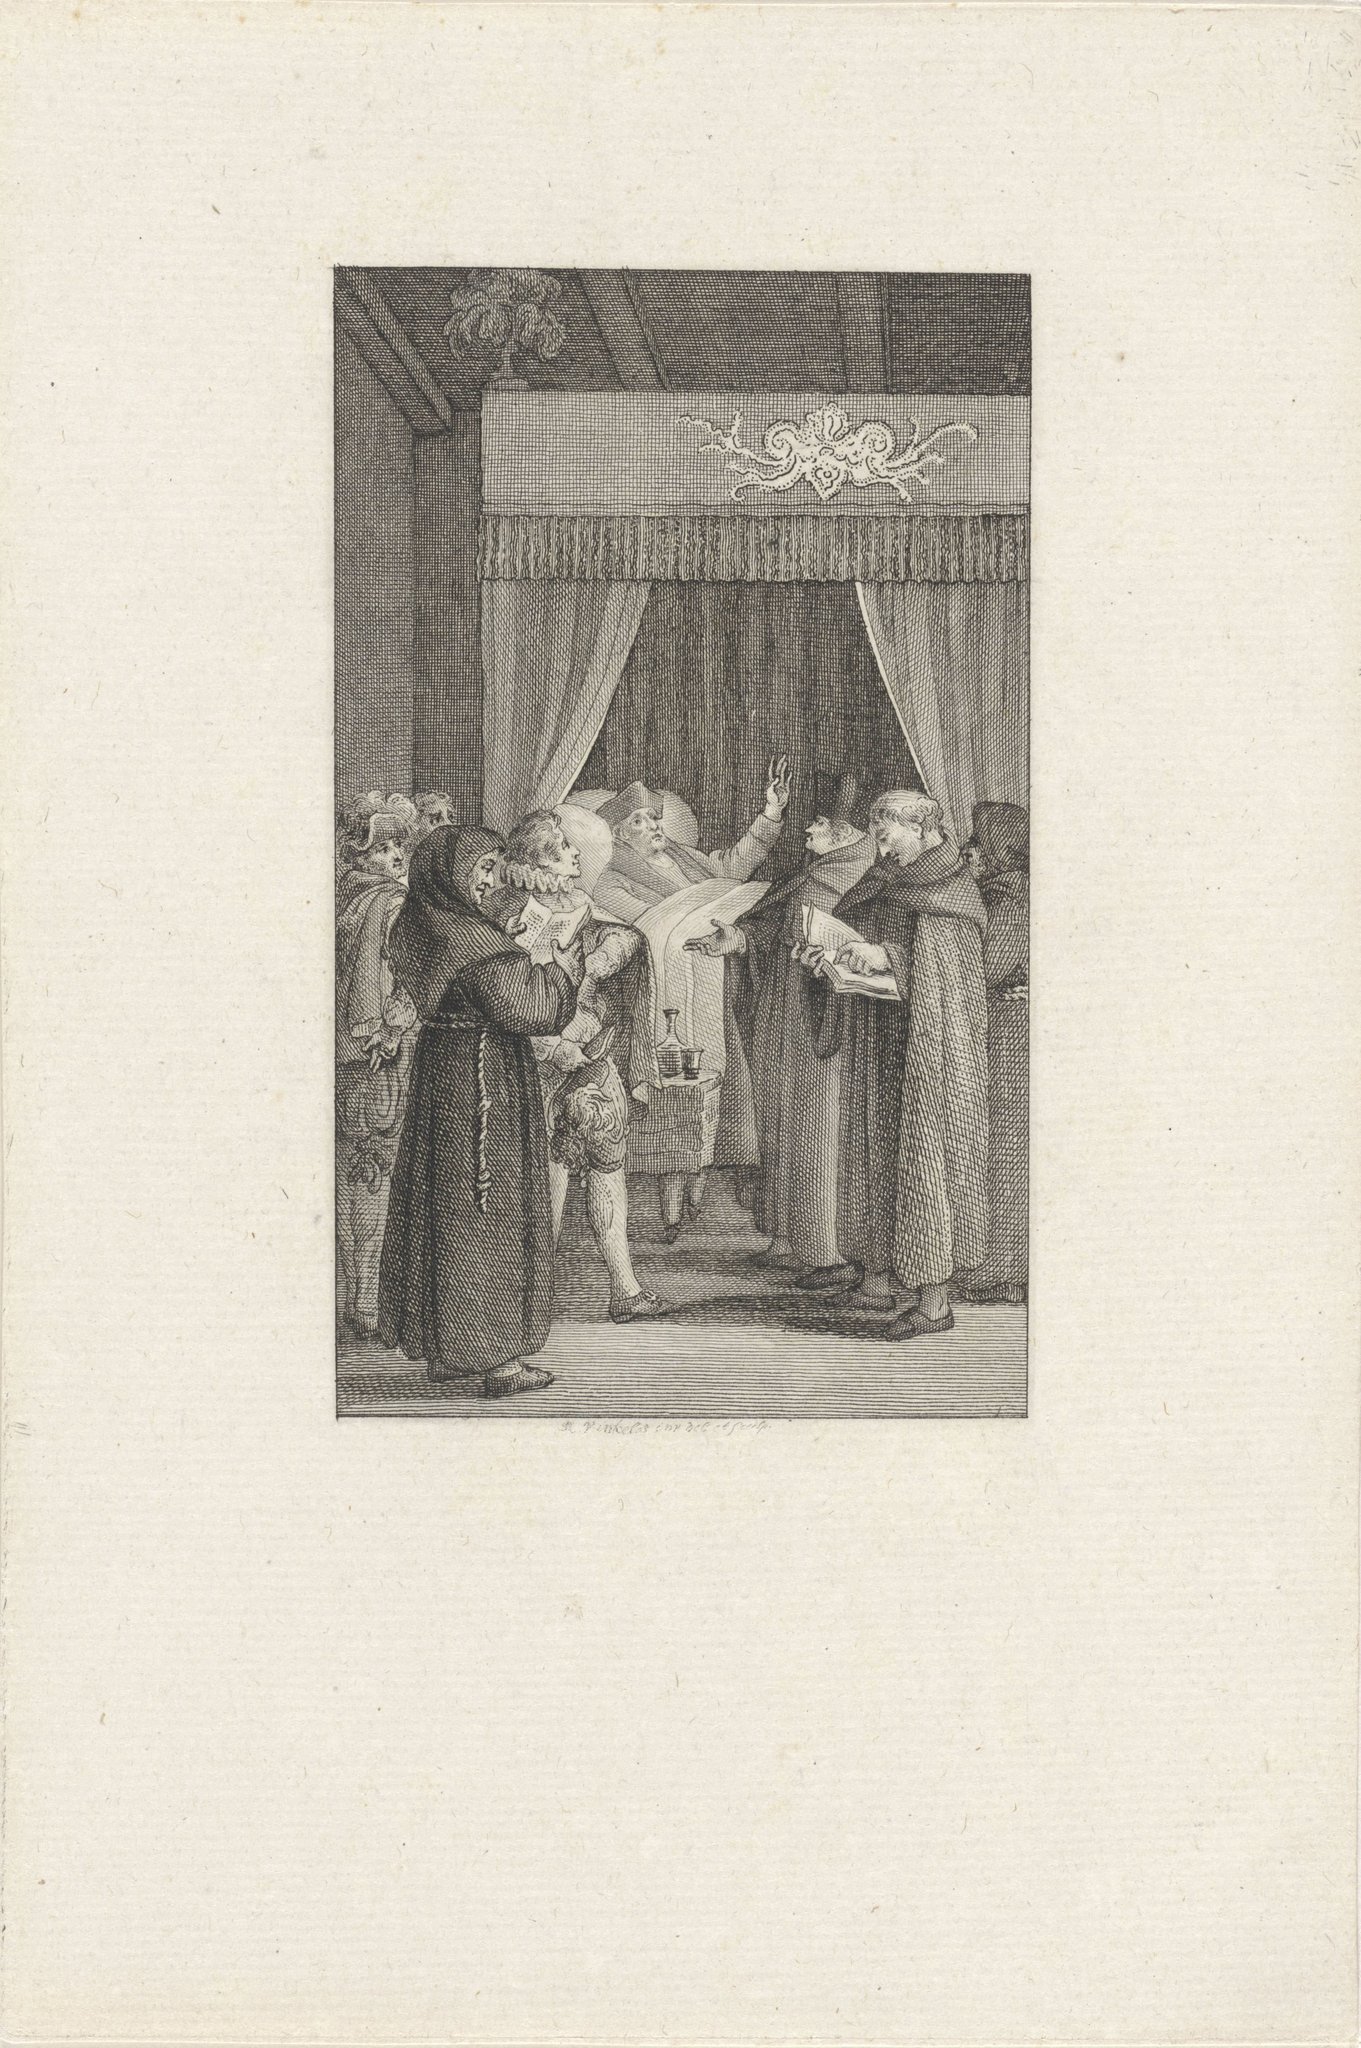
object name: print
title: John Wyclif berispt enkele monniken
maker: reinier vinkeles (i)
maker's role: draughtsman, print maker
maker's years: 1741-1816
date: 1809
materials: paper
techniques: engraving, etching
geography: amsterdam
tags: monk(s), friar(s), visiting the sick; sick person together with others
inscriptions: collector's mark: Lugt 2228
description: Proefdruk van illustratie in: Hamelsveld, Ysbrand van. Algemeene kerkelijke geschiedenis, der Christenen, deel 19. Haarlem: François Bohn, 1809, p. 376.